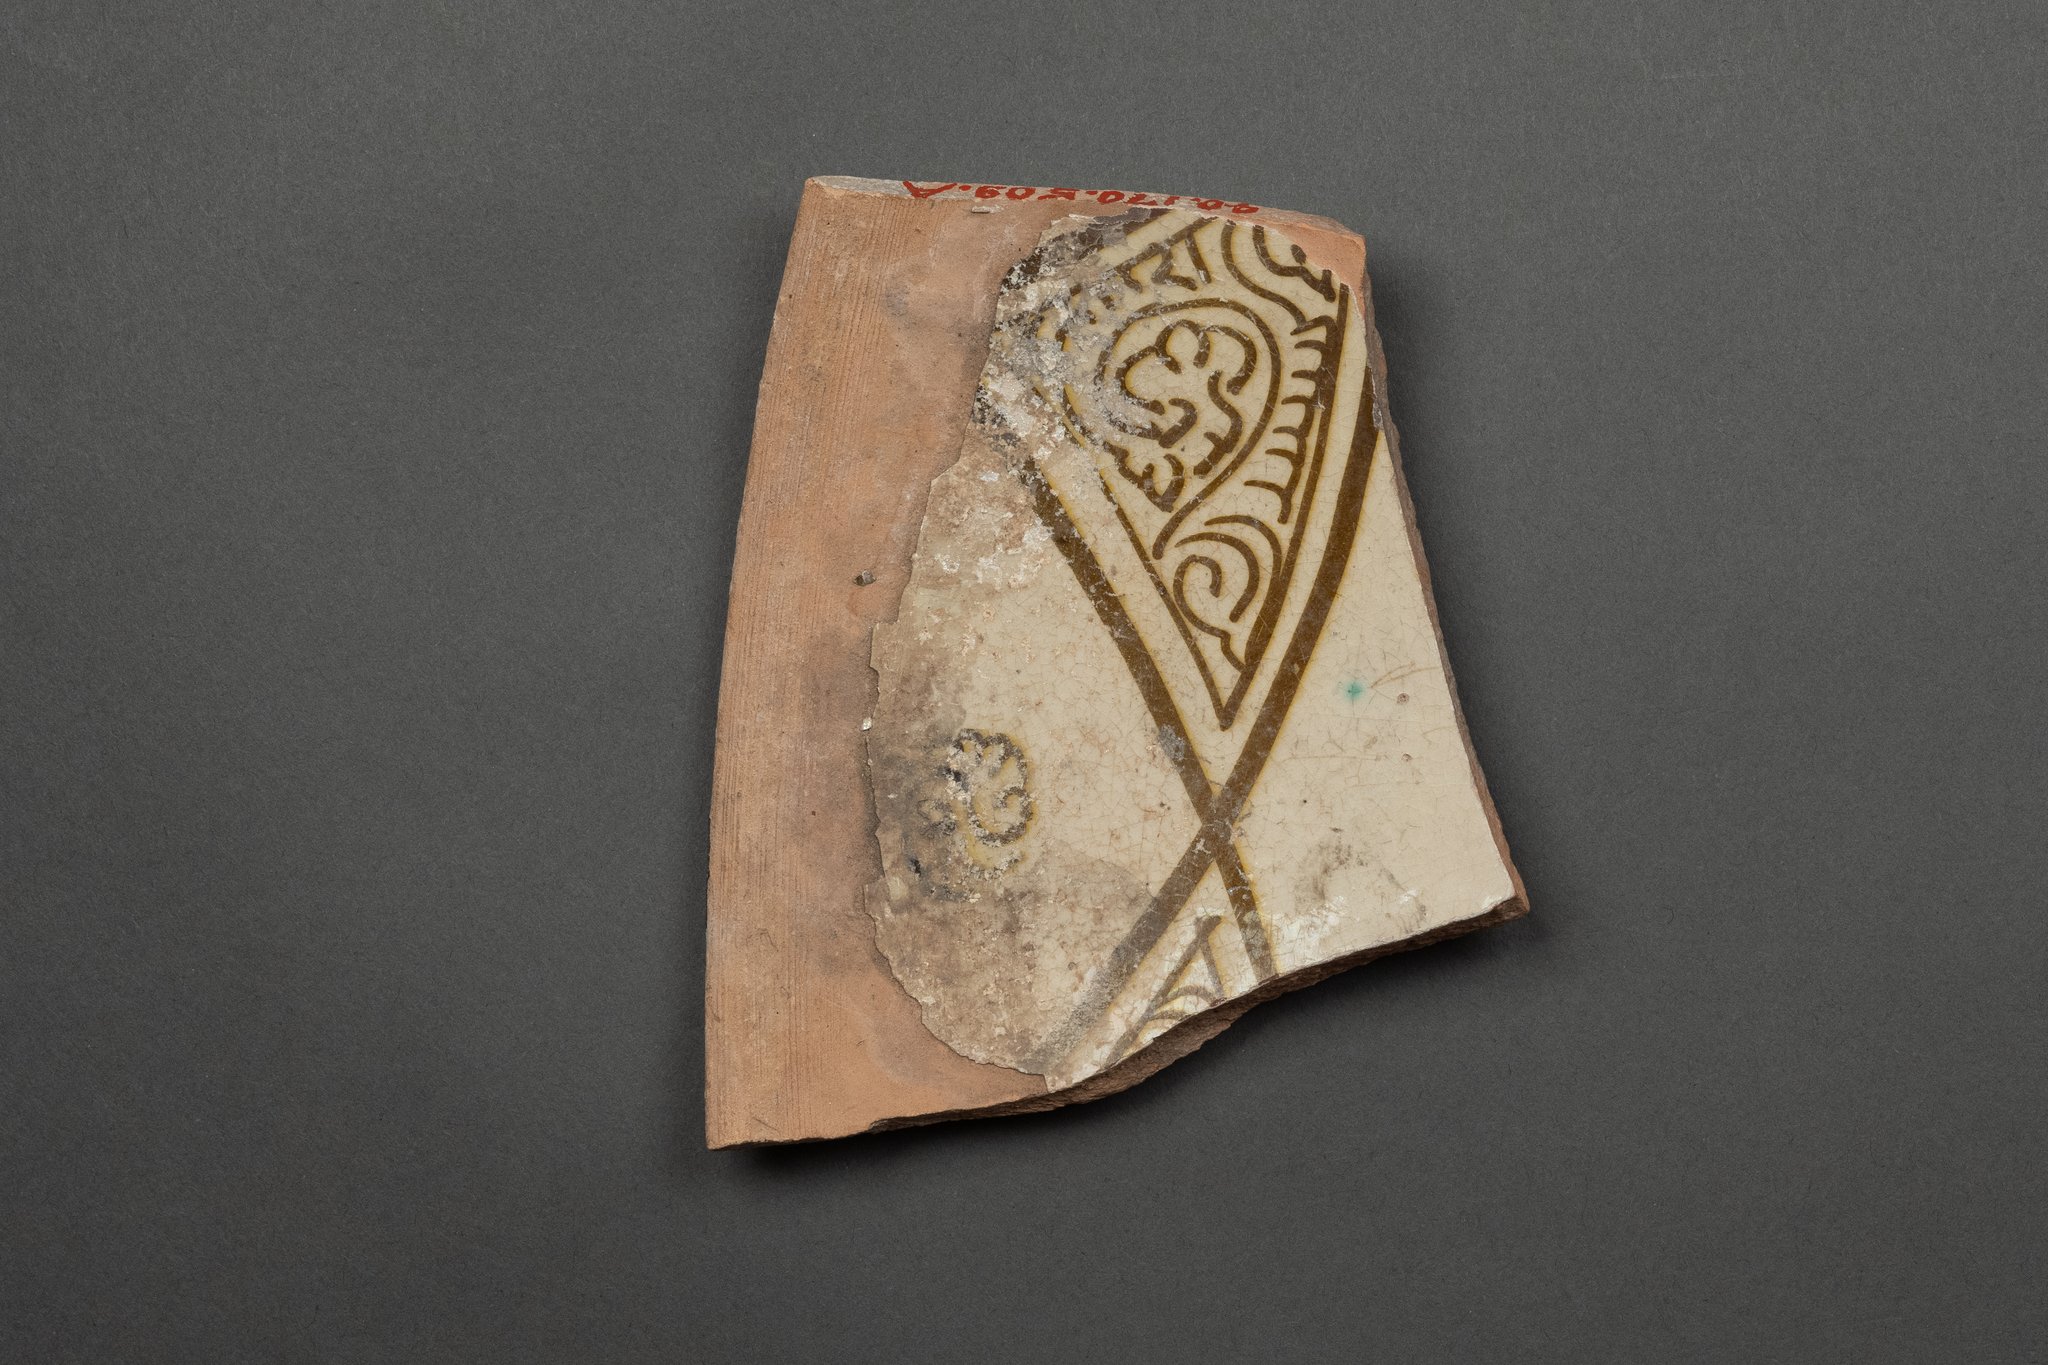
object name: fragment of a bowl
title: Fragments of a Bowl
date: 801-1000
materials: earthenware, glaze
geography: iran